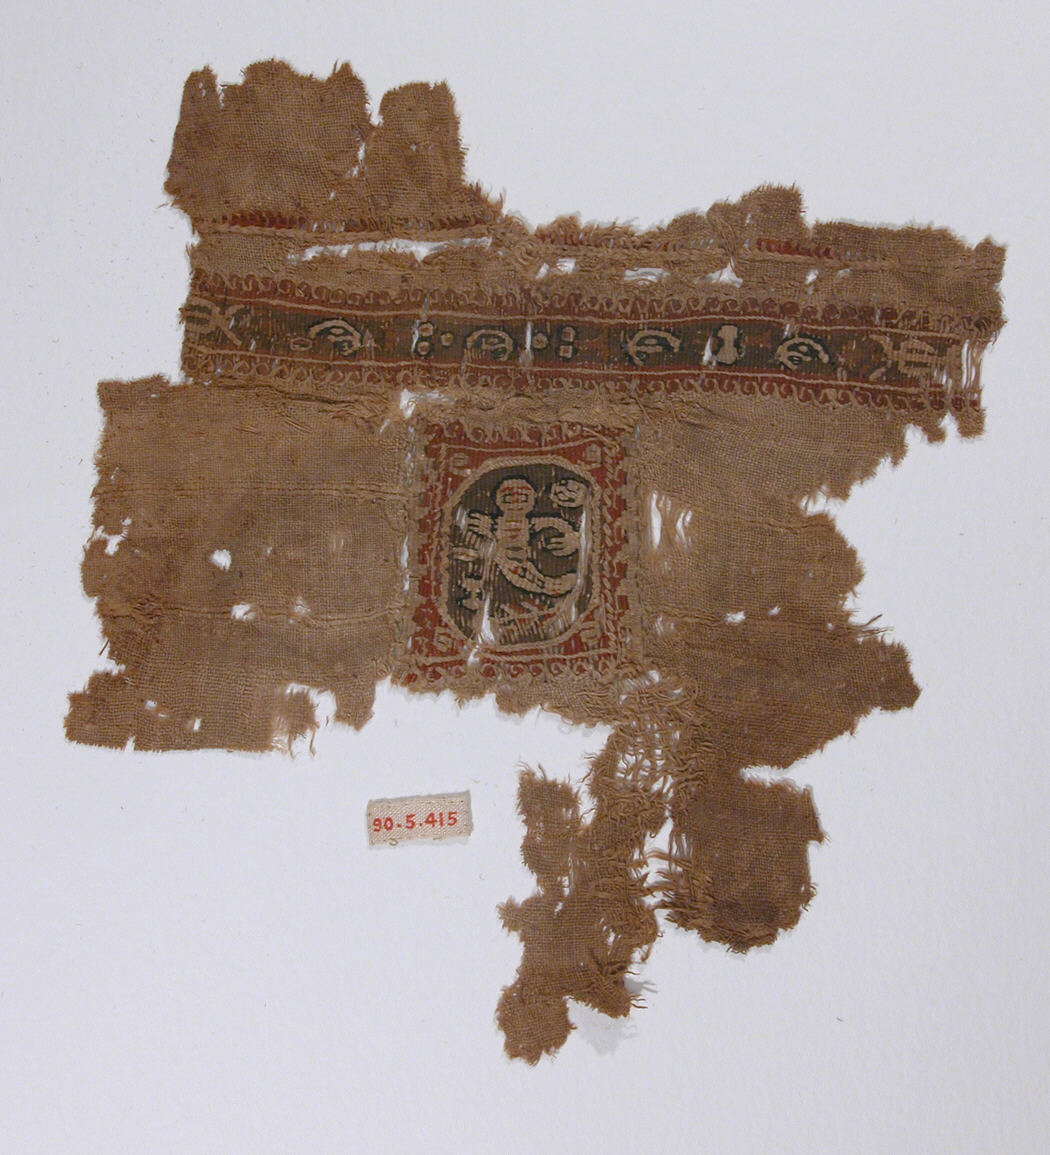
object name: textile fragment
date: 401-500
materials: linen, wool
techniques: weave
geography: egypt